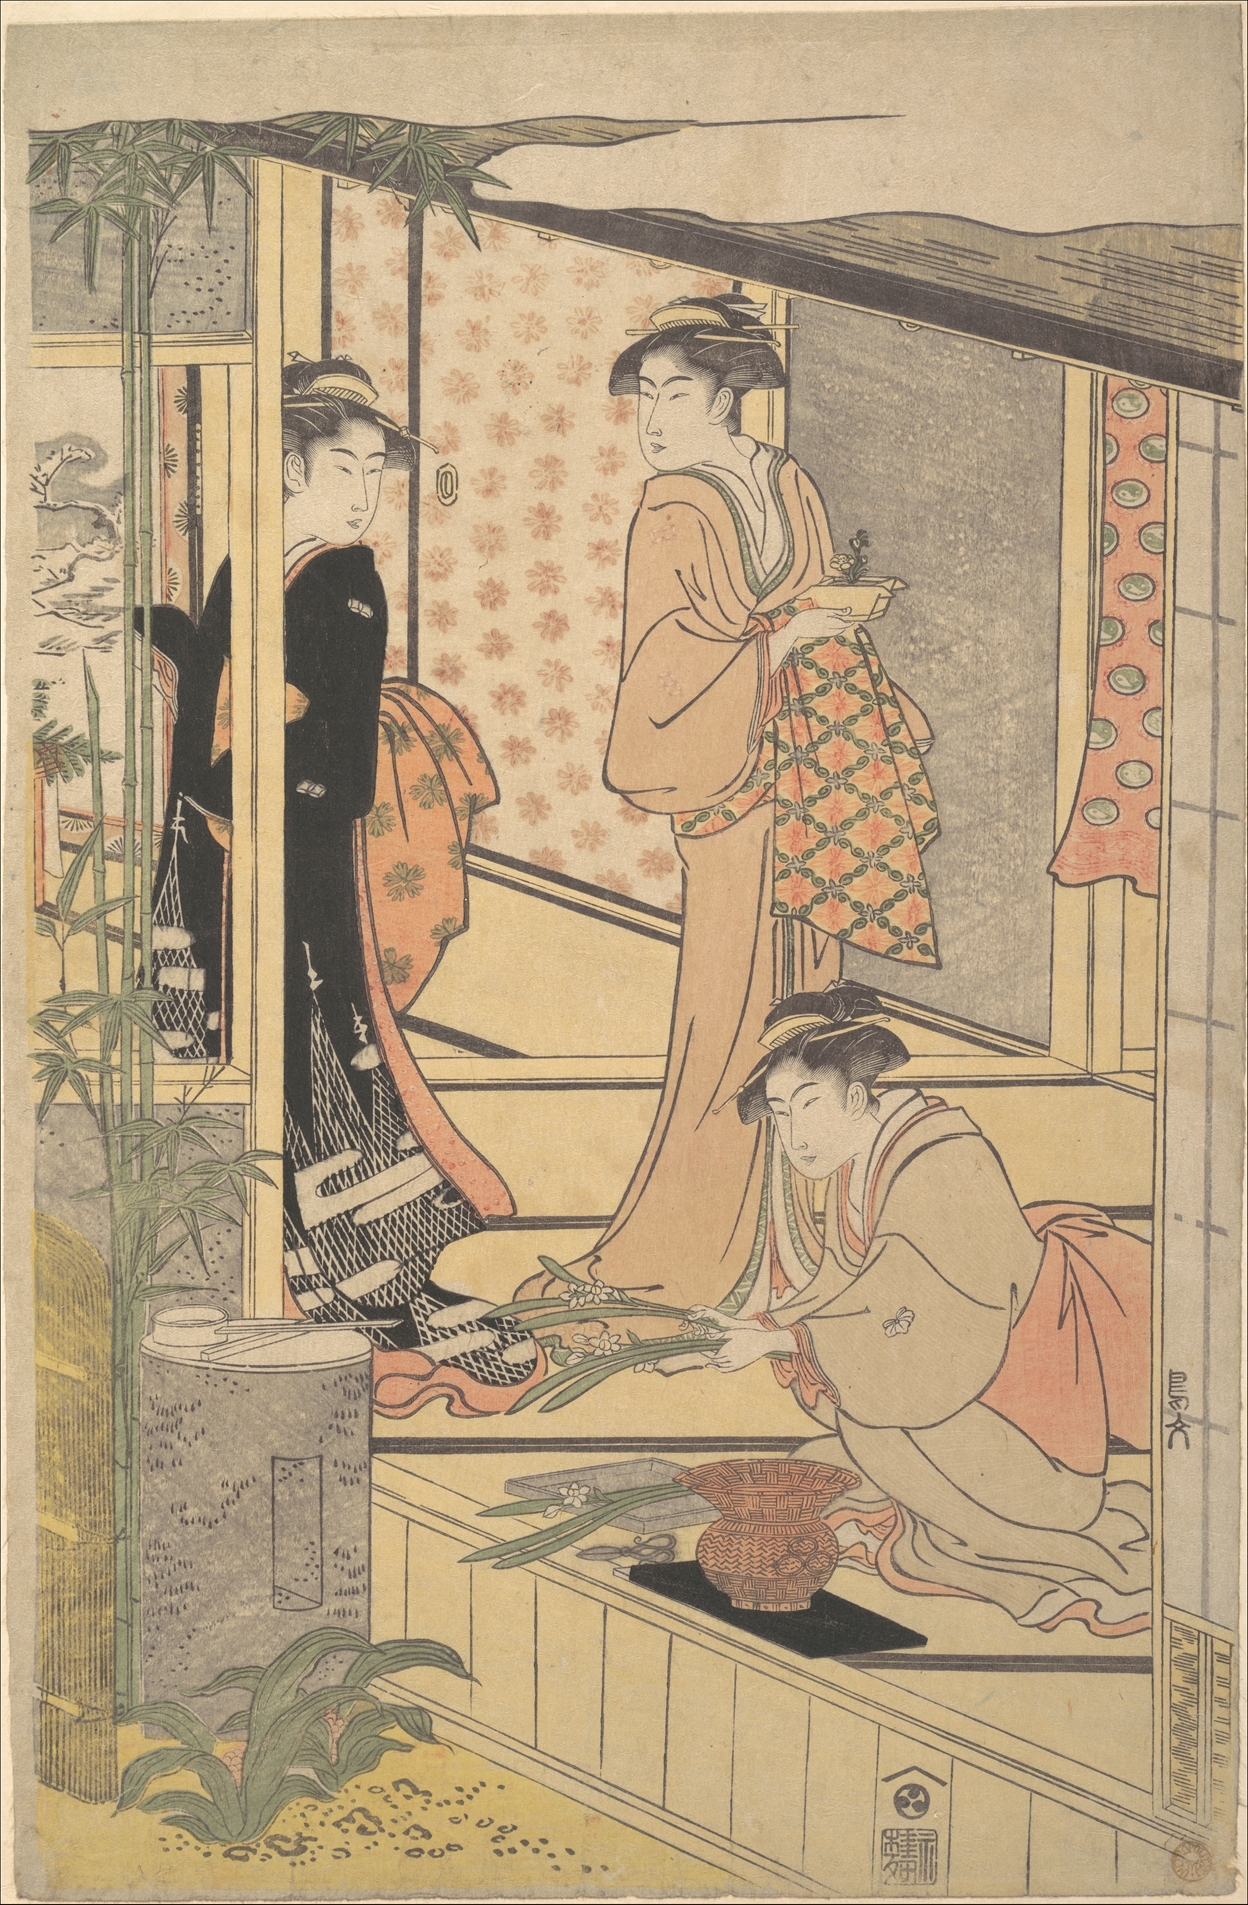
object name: print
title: Preparing New Year Decorations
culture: japanese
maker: hosoda eishi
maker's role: artist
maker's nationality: japanese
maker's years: 1756-1829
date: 1788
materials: ink, paper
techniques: woodblock print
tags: women,plants,working